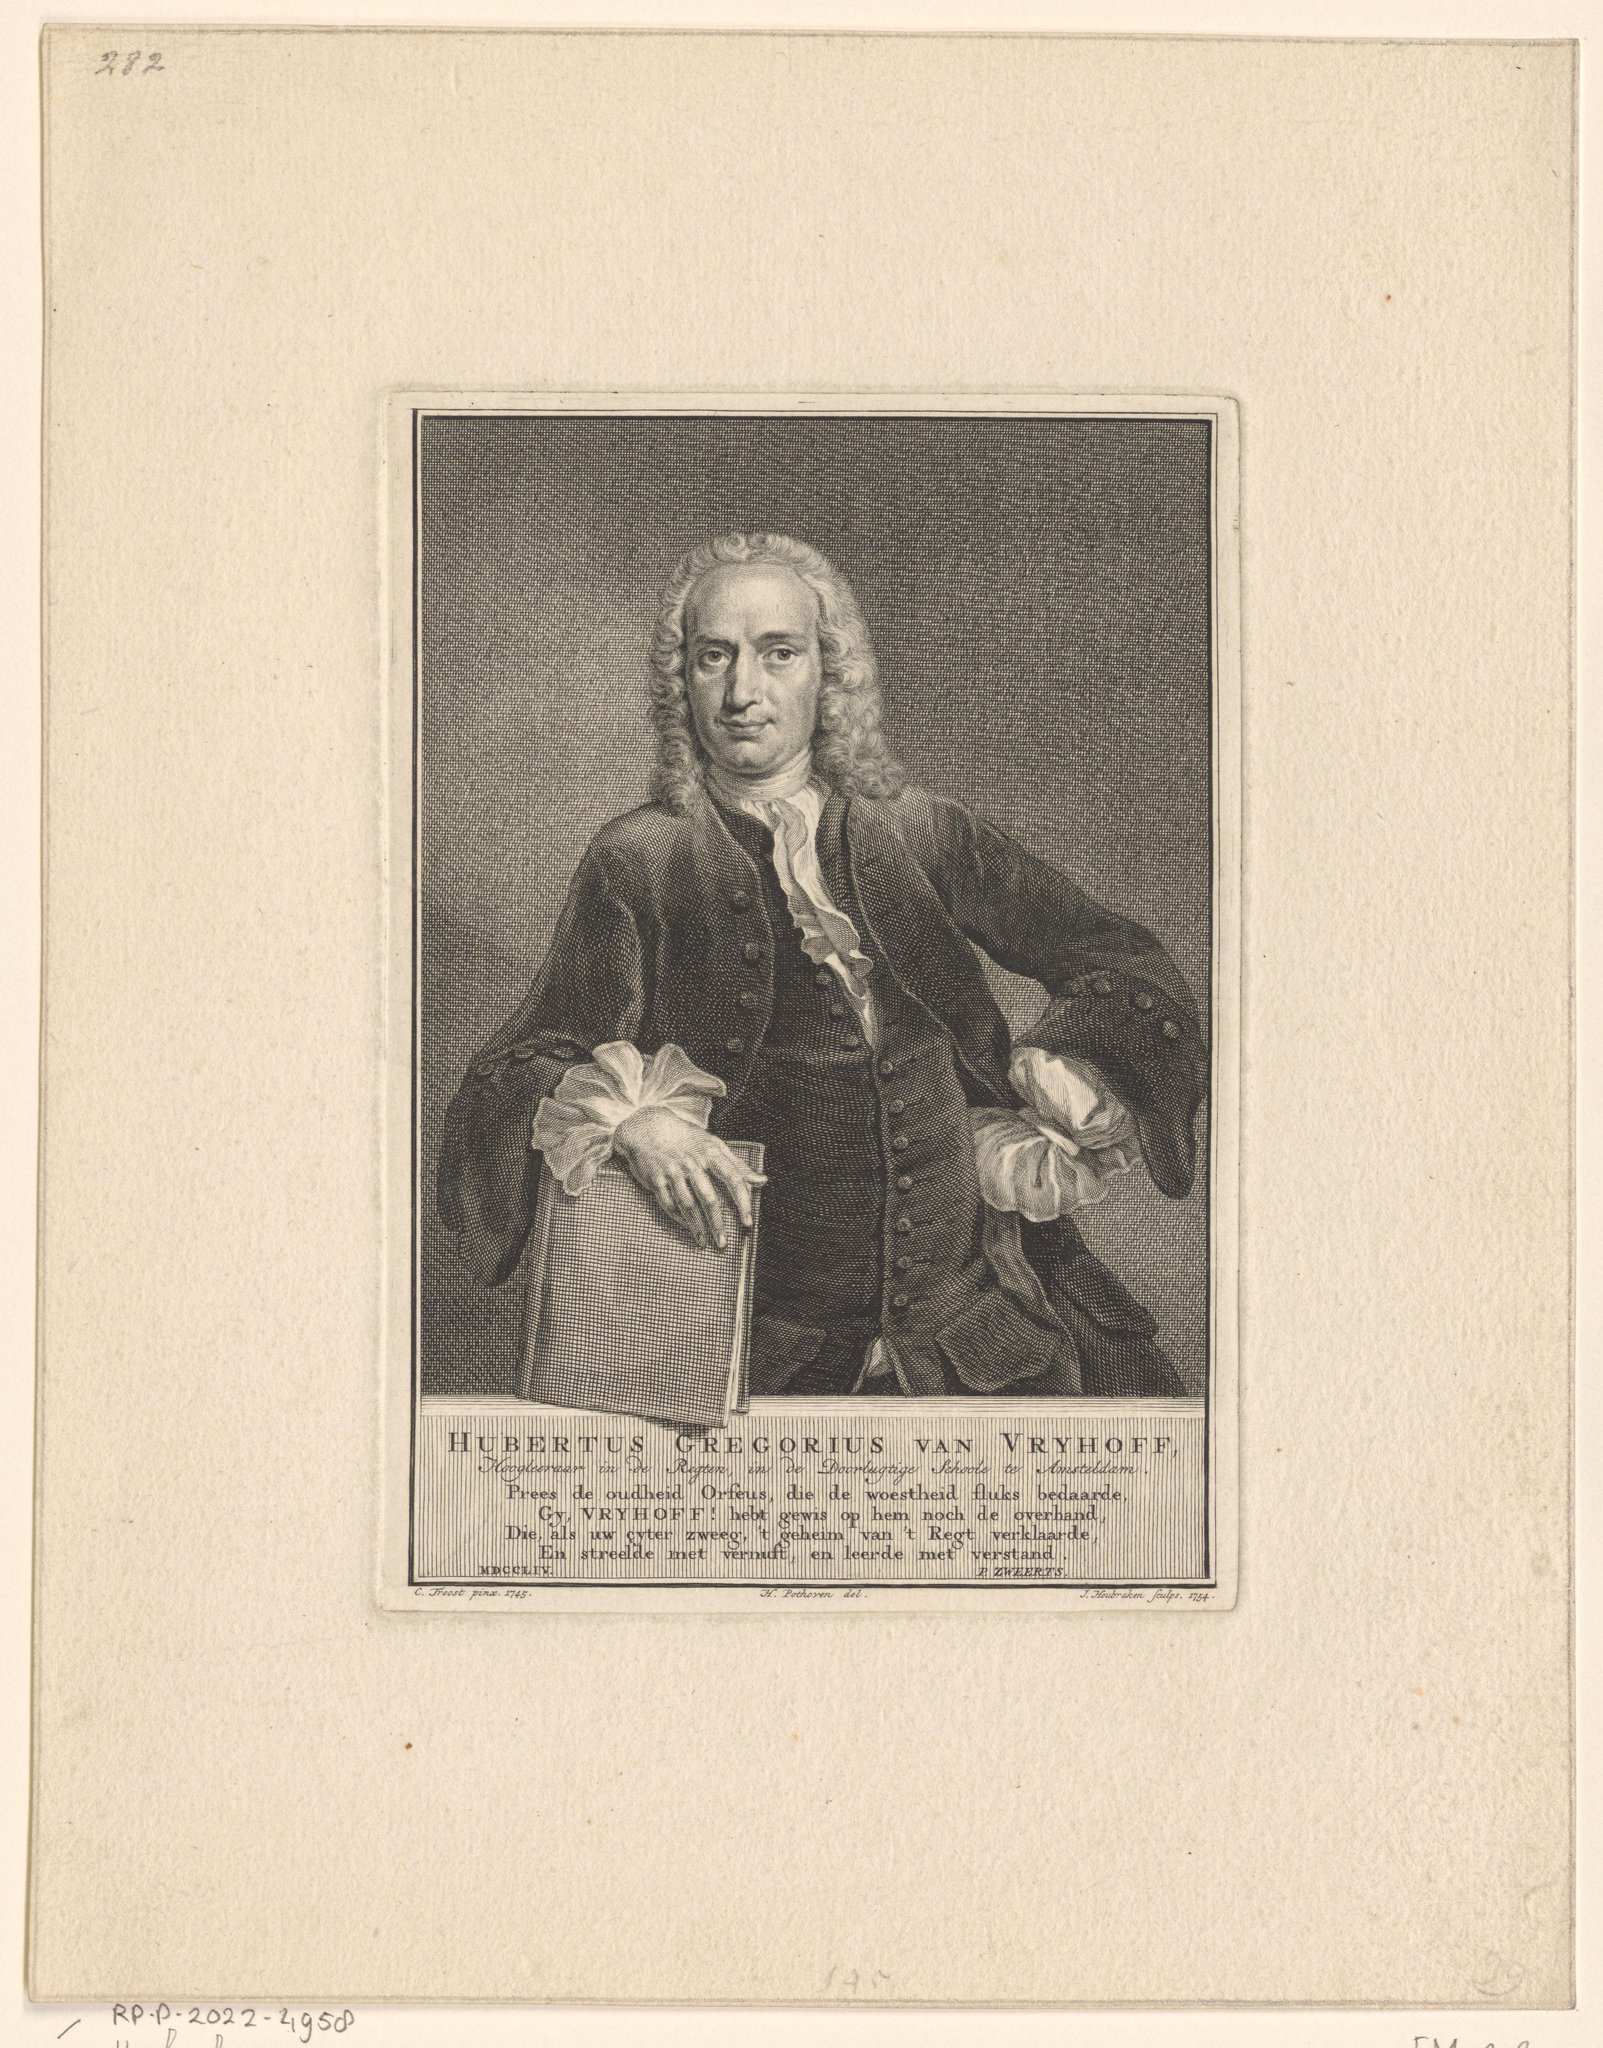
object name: print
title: Portret van Hubertus Gregorius van Vrijhoff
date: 1754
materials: paper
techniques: engraving, etching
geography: amsterdam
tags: amsterdam, scholar, philosopher, historical persons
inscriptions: collector's mark: Lugt 2228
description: Prent ook gebruikt in: Vrijhoff, Hubert Gregorius van. De gedigten van H.G. van Vryhoff. Amsterdam: Jan Roman (II), 1755.